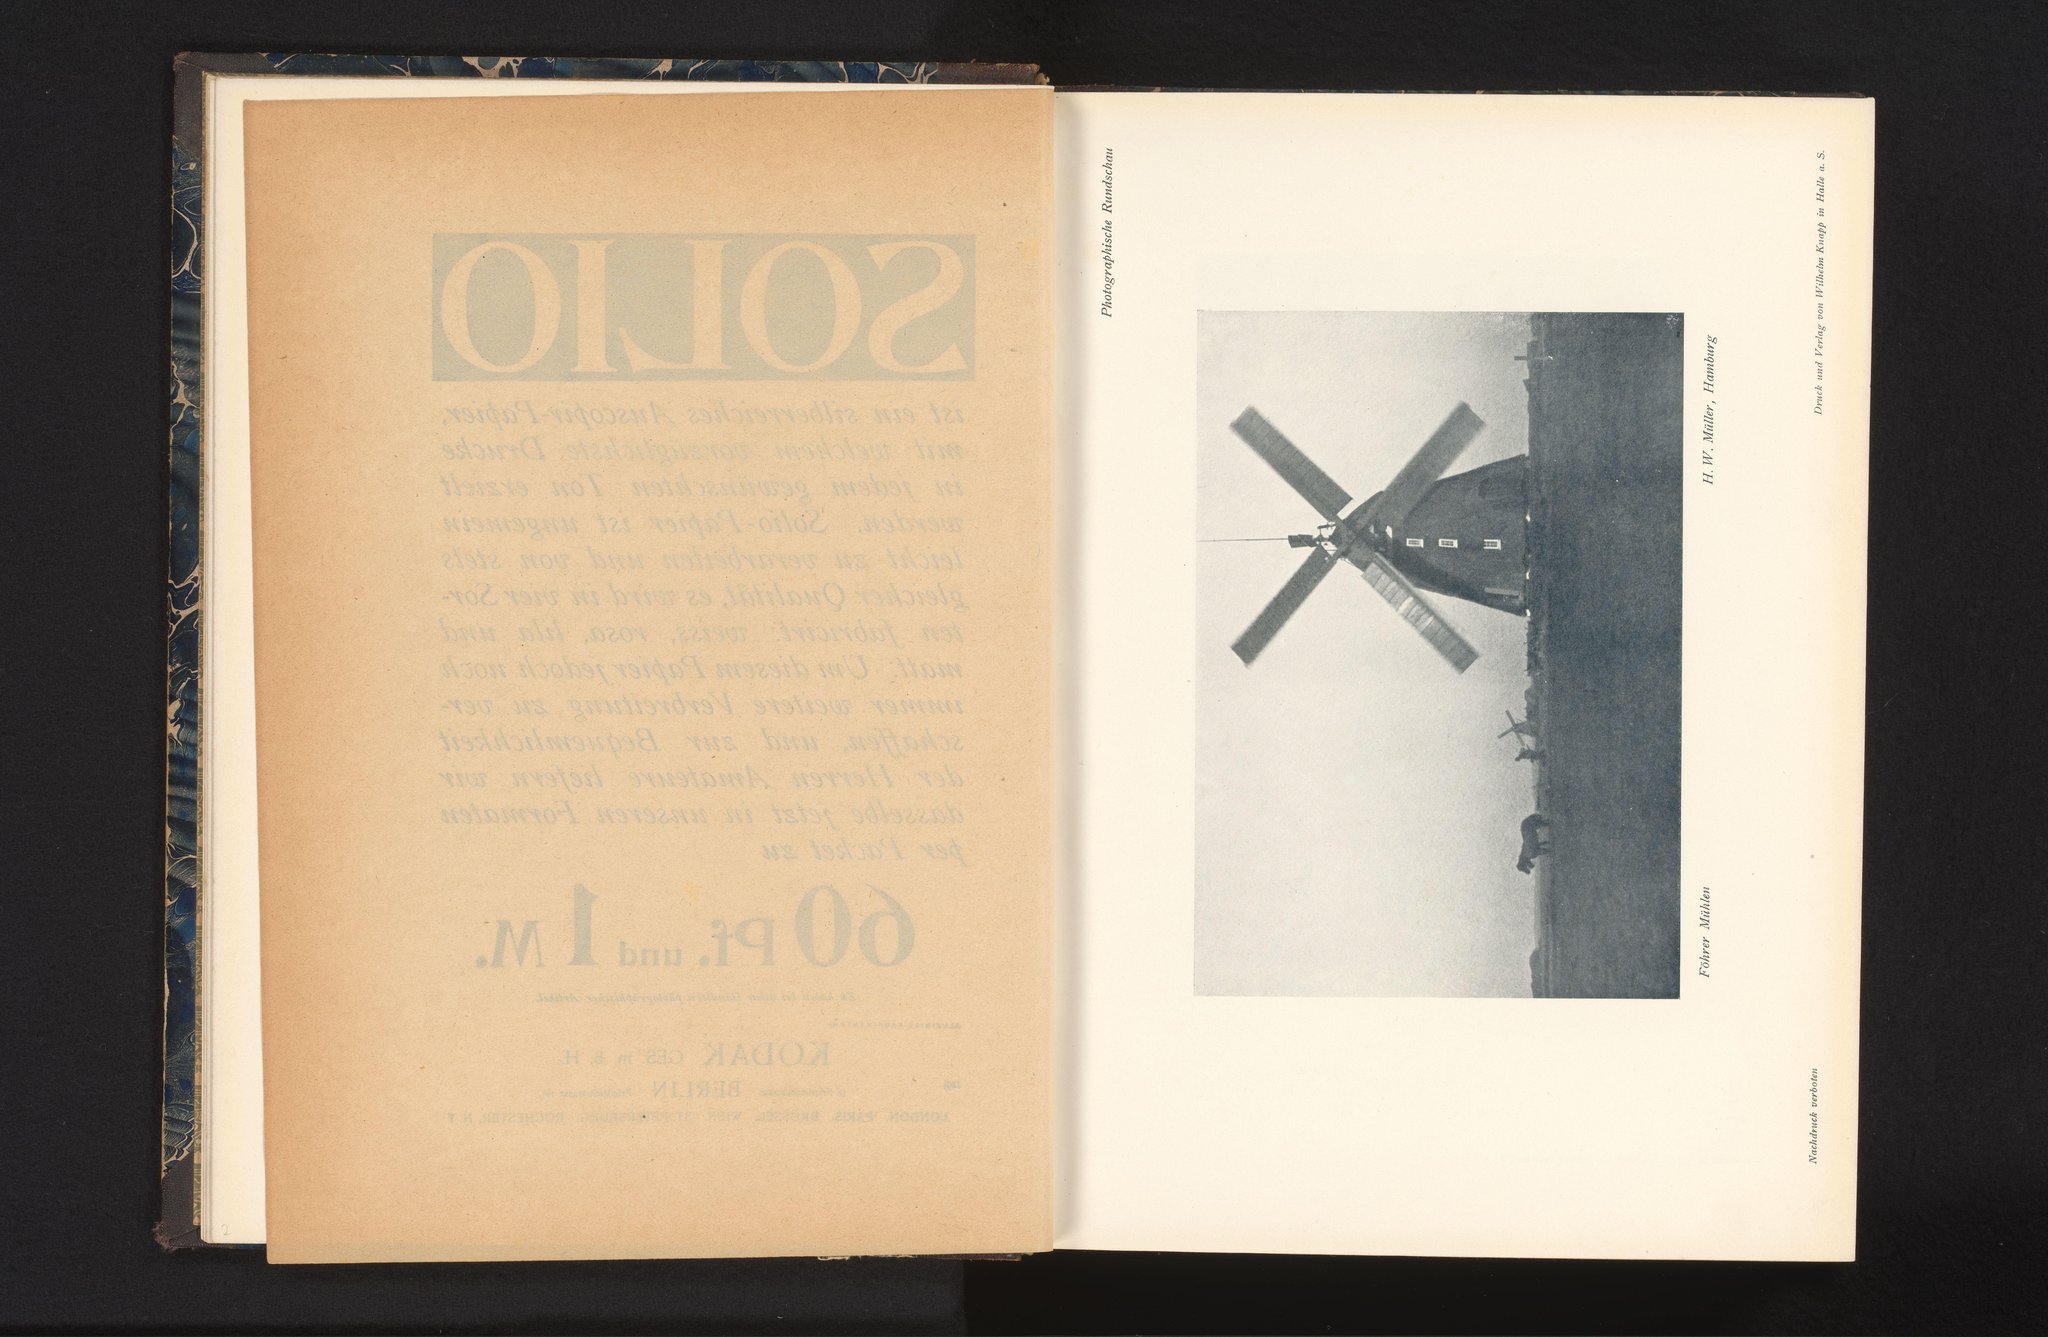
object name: page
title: Föhrer Mühlen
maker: h.w. müller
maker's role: fotograaf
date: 1897-1902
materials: paper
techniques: autotype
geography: berlin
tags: windmill in landscape, horse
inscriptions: monogram: ‘MR&C’